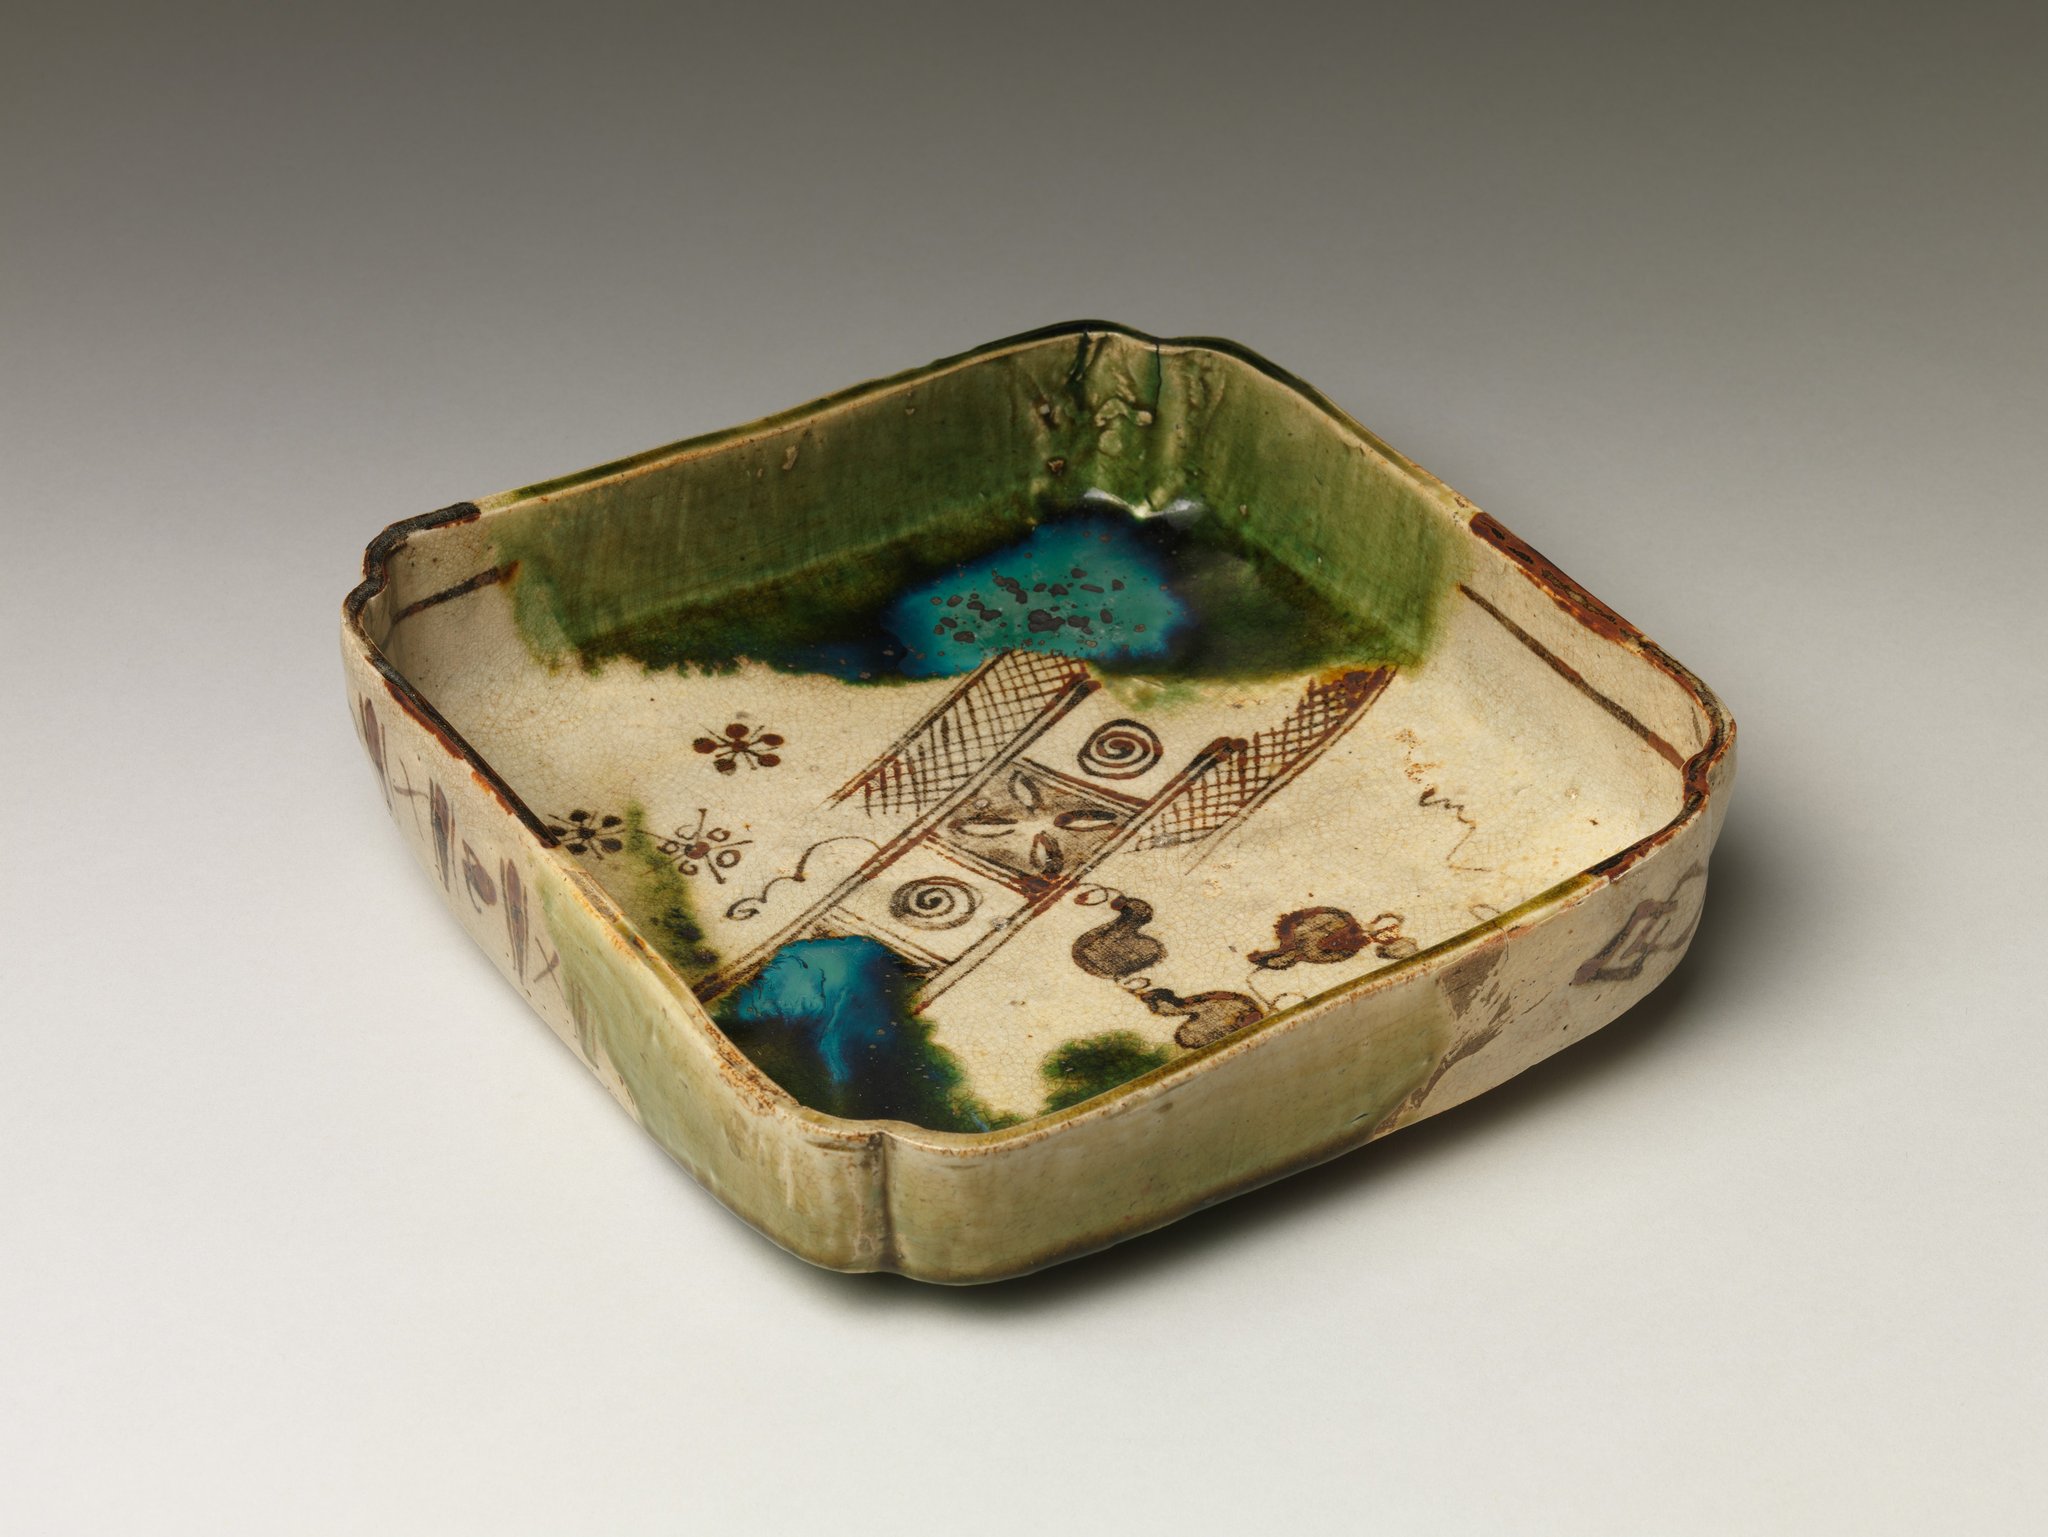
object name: dish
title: Square Dish with Abstract Motifs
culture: japanese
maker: shuntai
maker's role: artist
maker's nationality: japanese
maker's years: 1799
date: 1801-1900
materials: stoneware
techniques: glazing